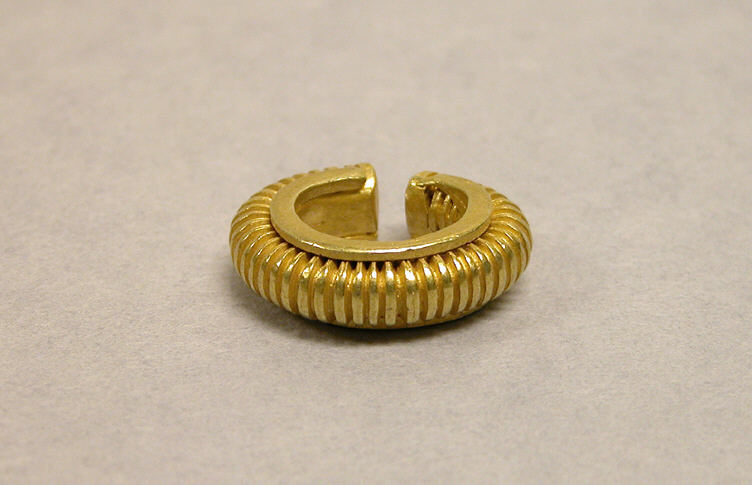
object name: ear ornament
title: Pair of Ear Ornaments with Design of Fused Discs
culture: indonesian, central java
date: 701-1200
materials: gold